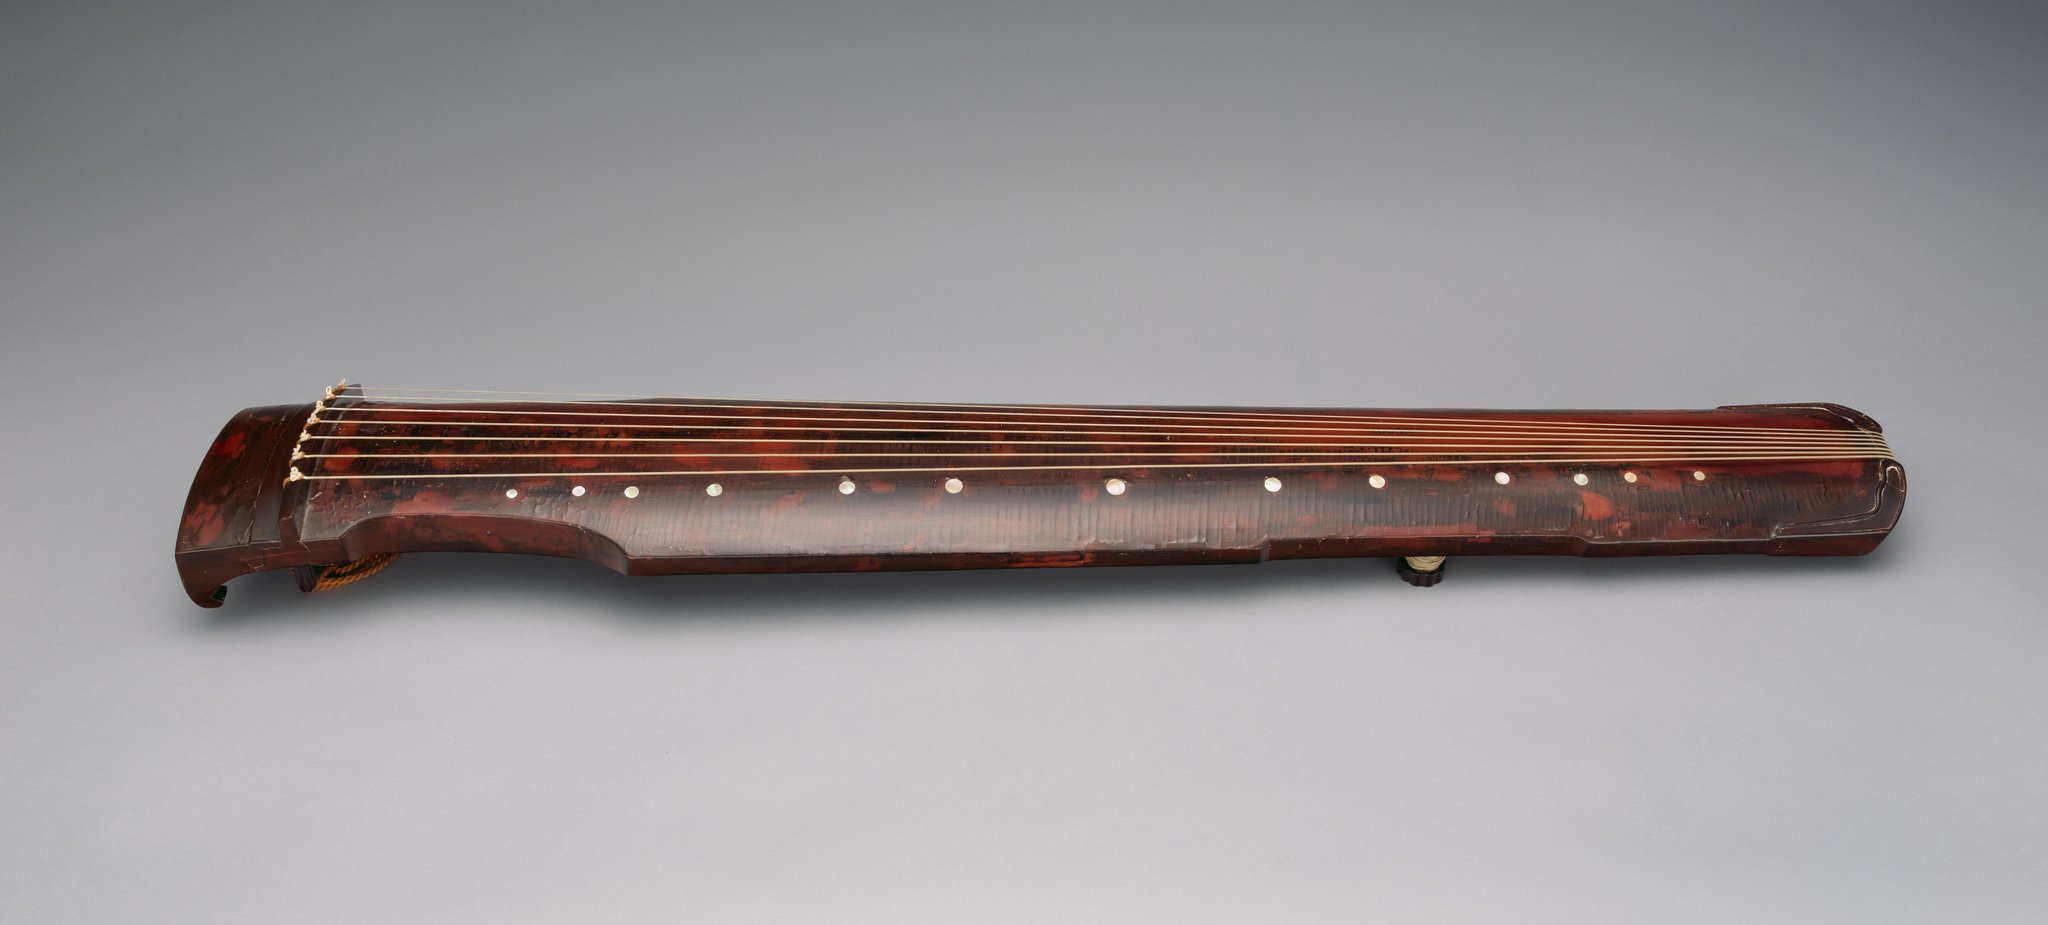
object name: qin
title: Guqin (古琴 )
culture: chinese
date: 1667-1766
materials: mother of pearl, silk, wood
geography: china